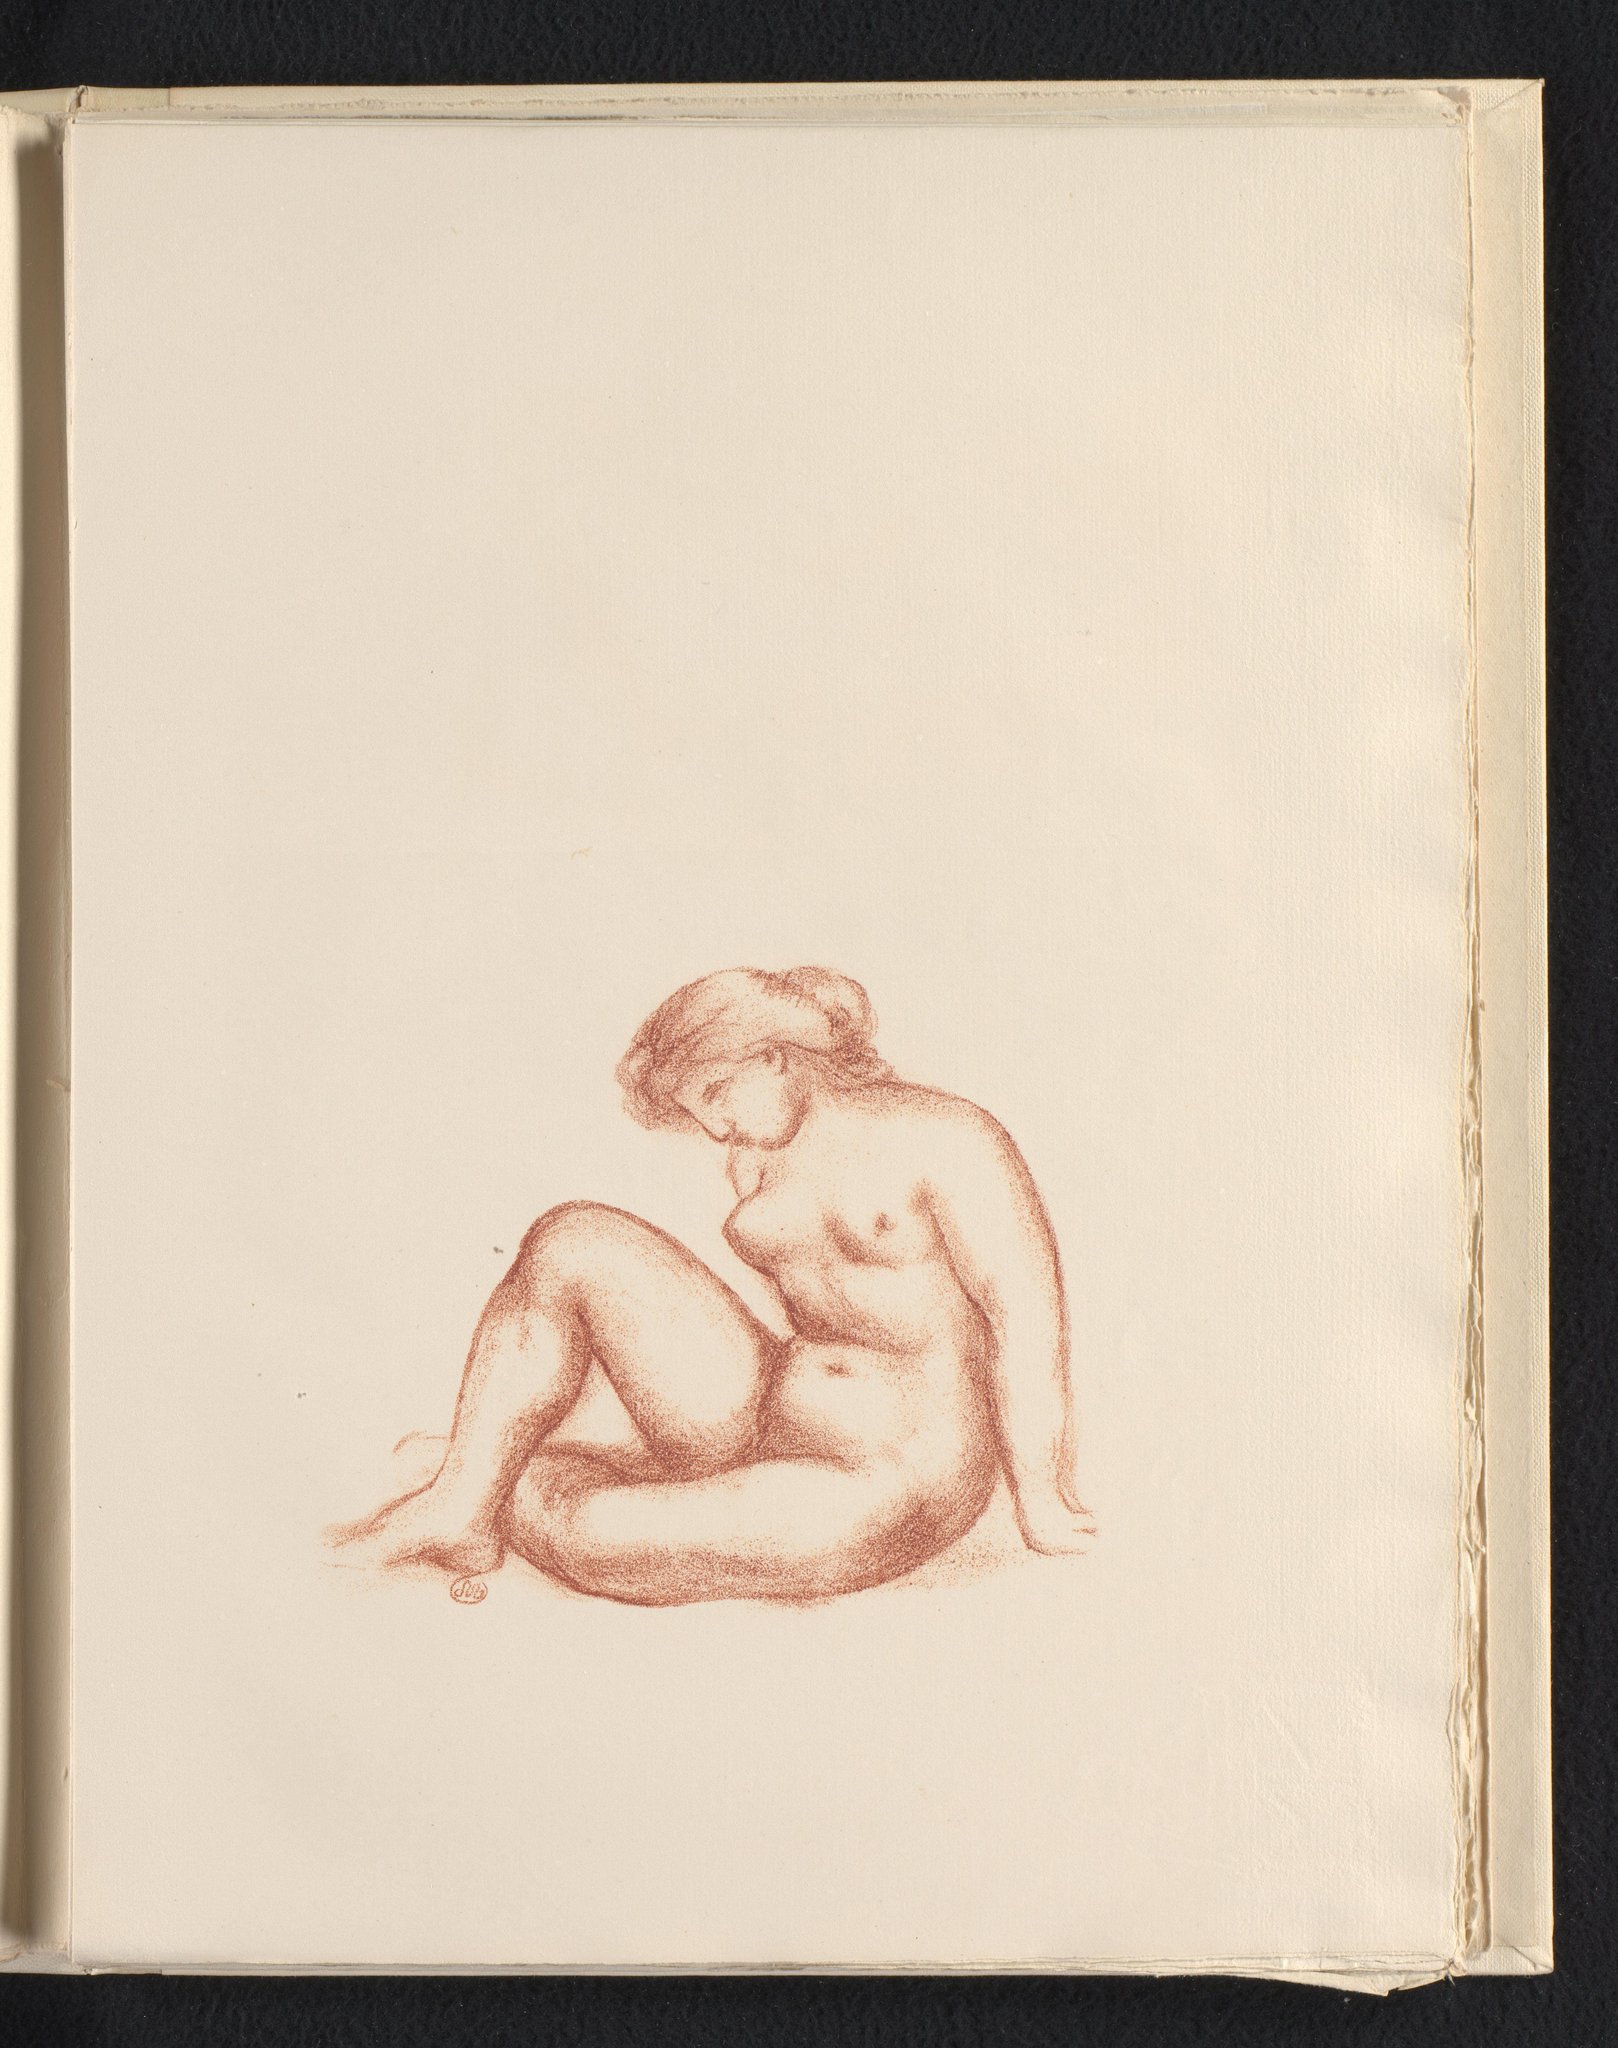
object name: print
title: Op de grond zittende naakte vrouw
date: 1948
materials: paper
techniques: lithograph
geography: paris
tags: sitting figure - aa - female human figure, woman (showing herself) undressed, quasi-nude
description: Prent uit: Lucianus van Samosata. Dialogues des Courtisanes. [Vertaald uit het Grieks door] Charles Astruc. Parijs: s.n., 1948, deel van de suite met een extra afdruk van de prenten in sanguine.